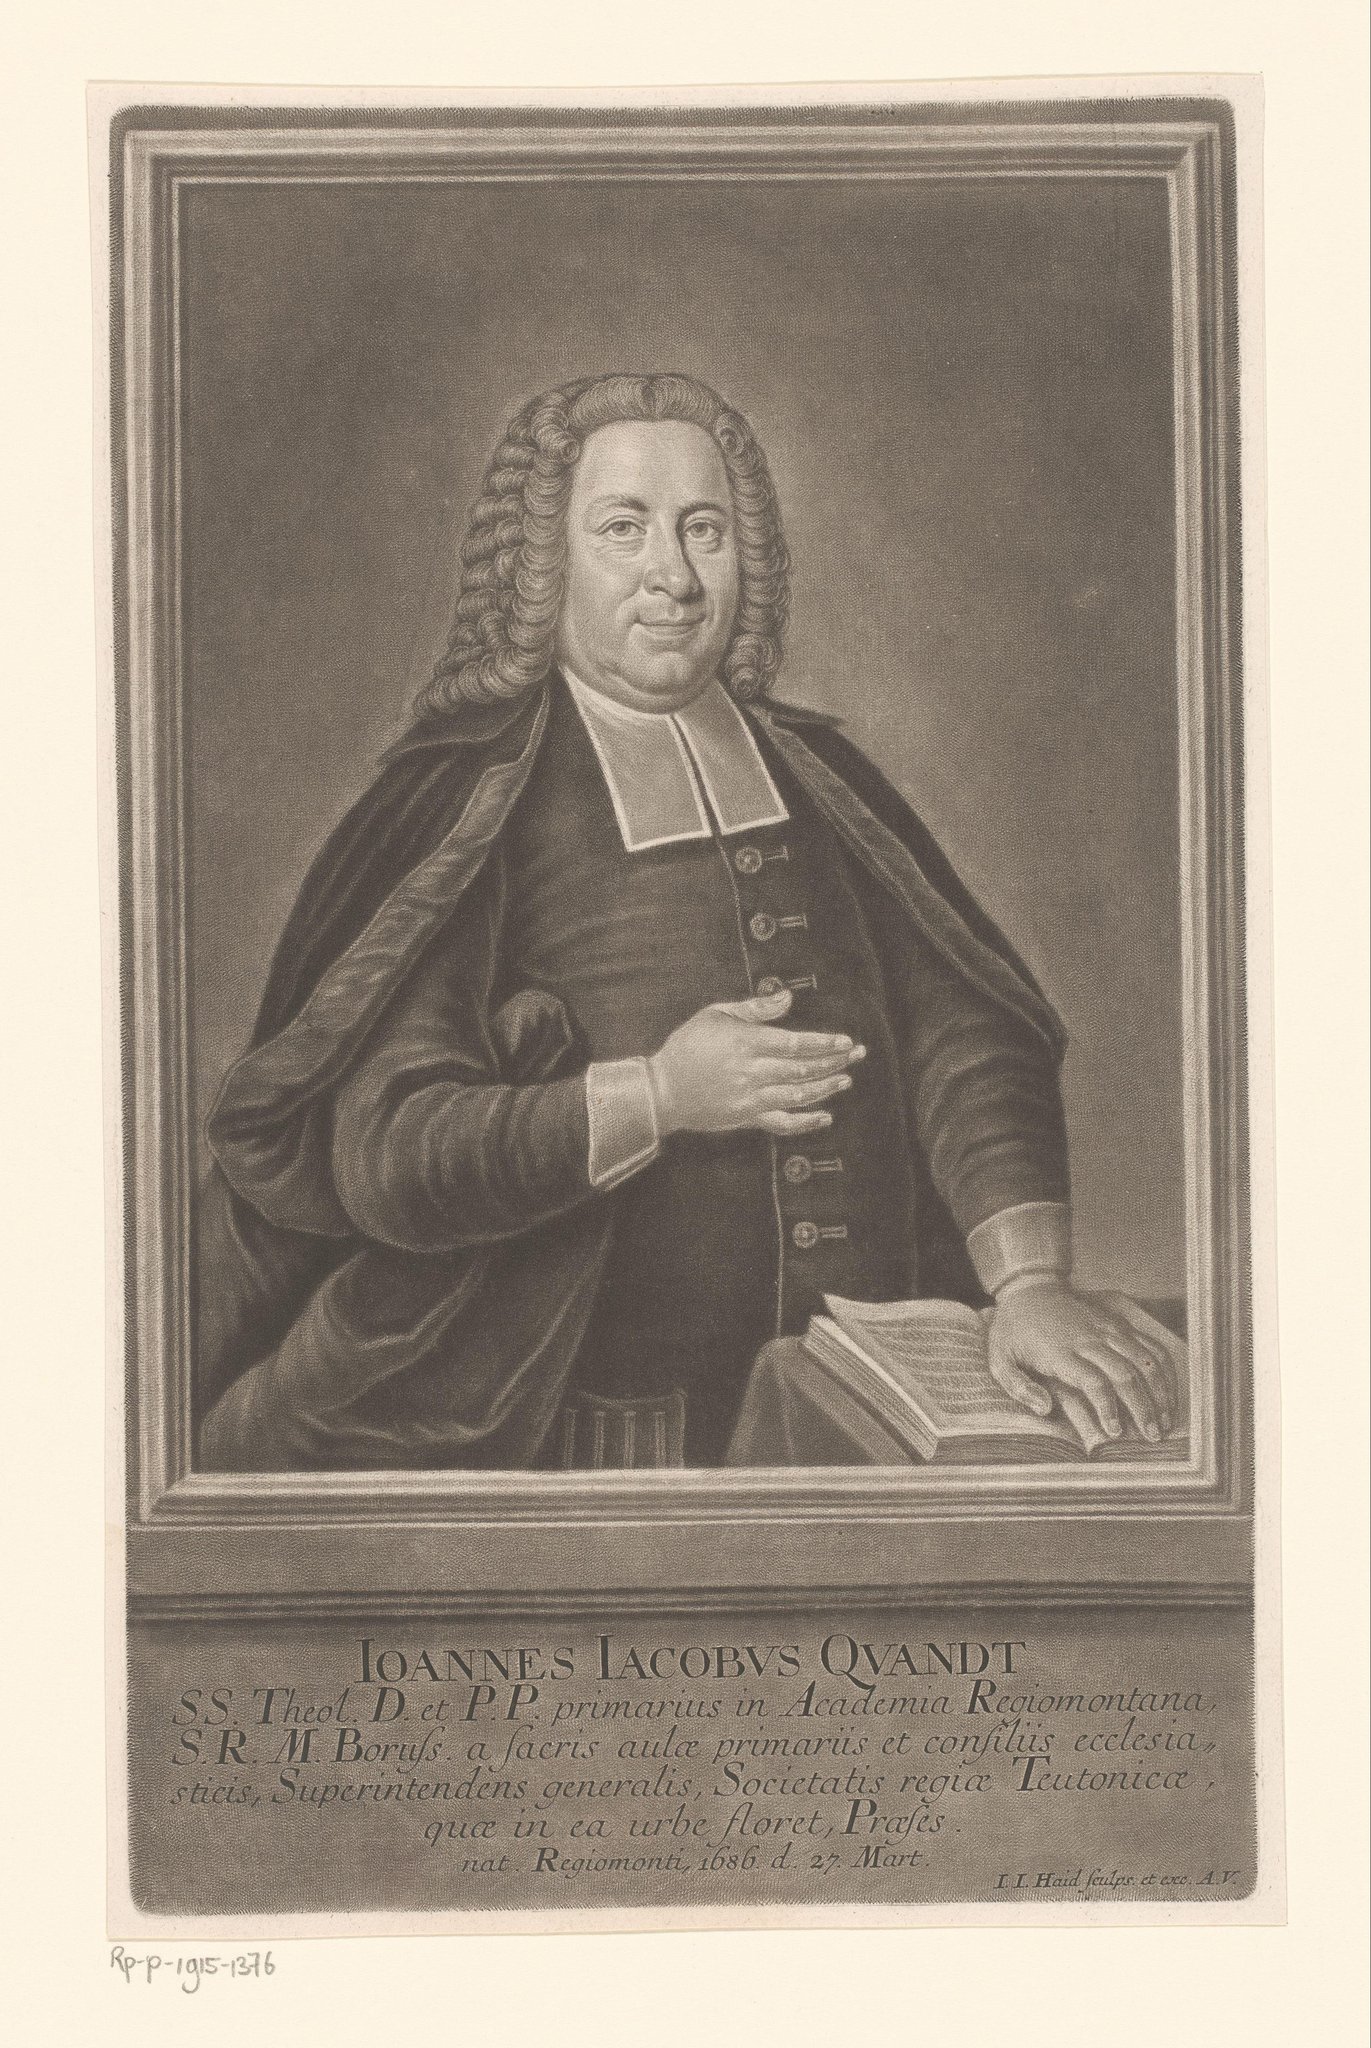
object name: print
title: Portret van Johann Jakob Quandt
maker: johann jacob haid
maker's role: print maker, publisher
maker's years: 1704-1767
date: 1714-1767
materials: paper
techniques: mezzotint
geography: augsburg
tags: historical persons, book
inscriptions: collector's mark: Lugt 2228